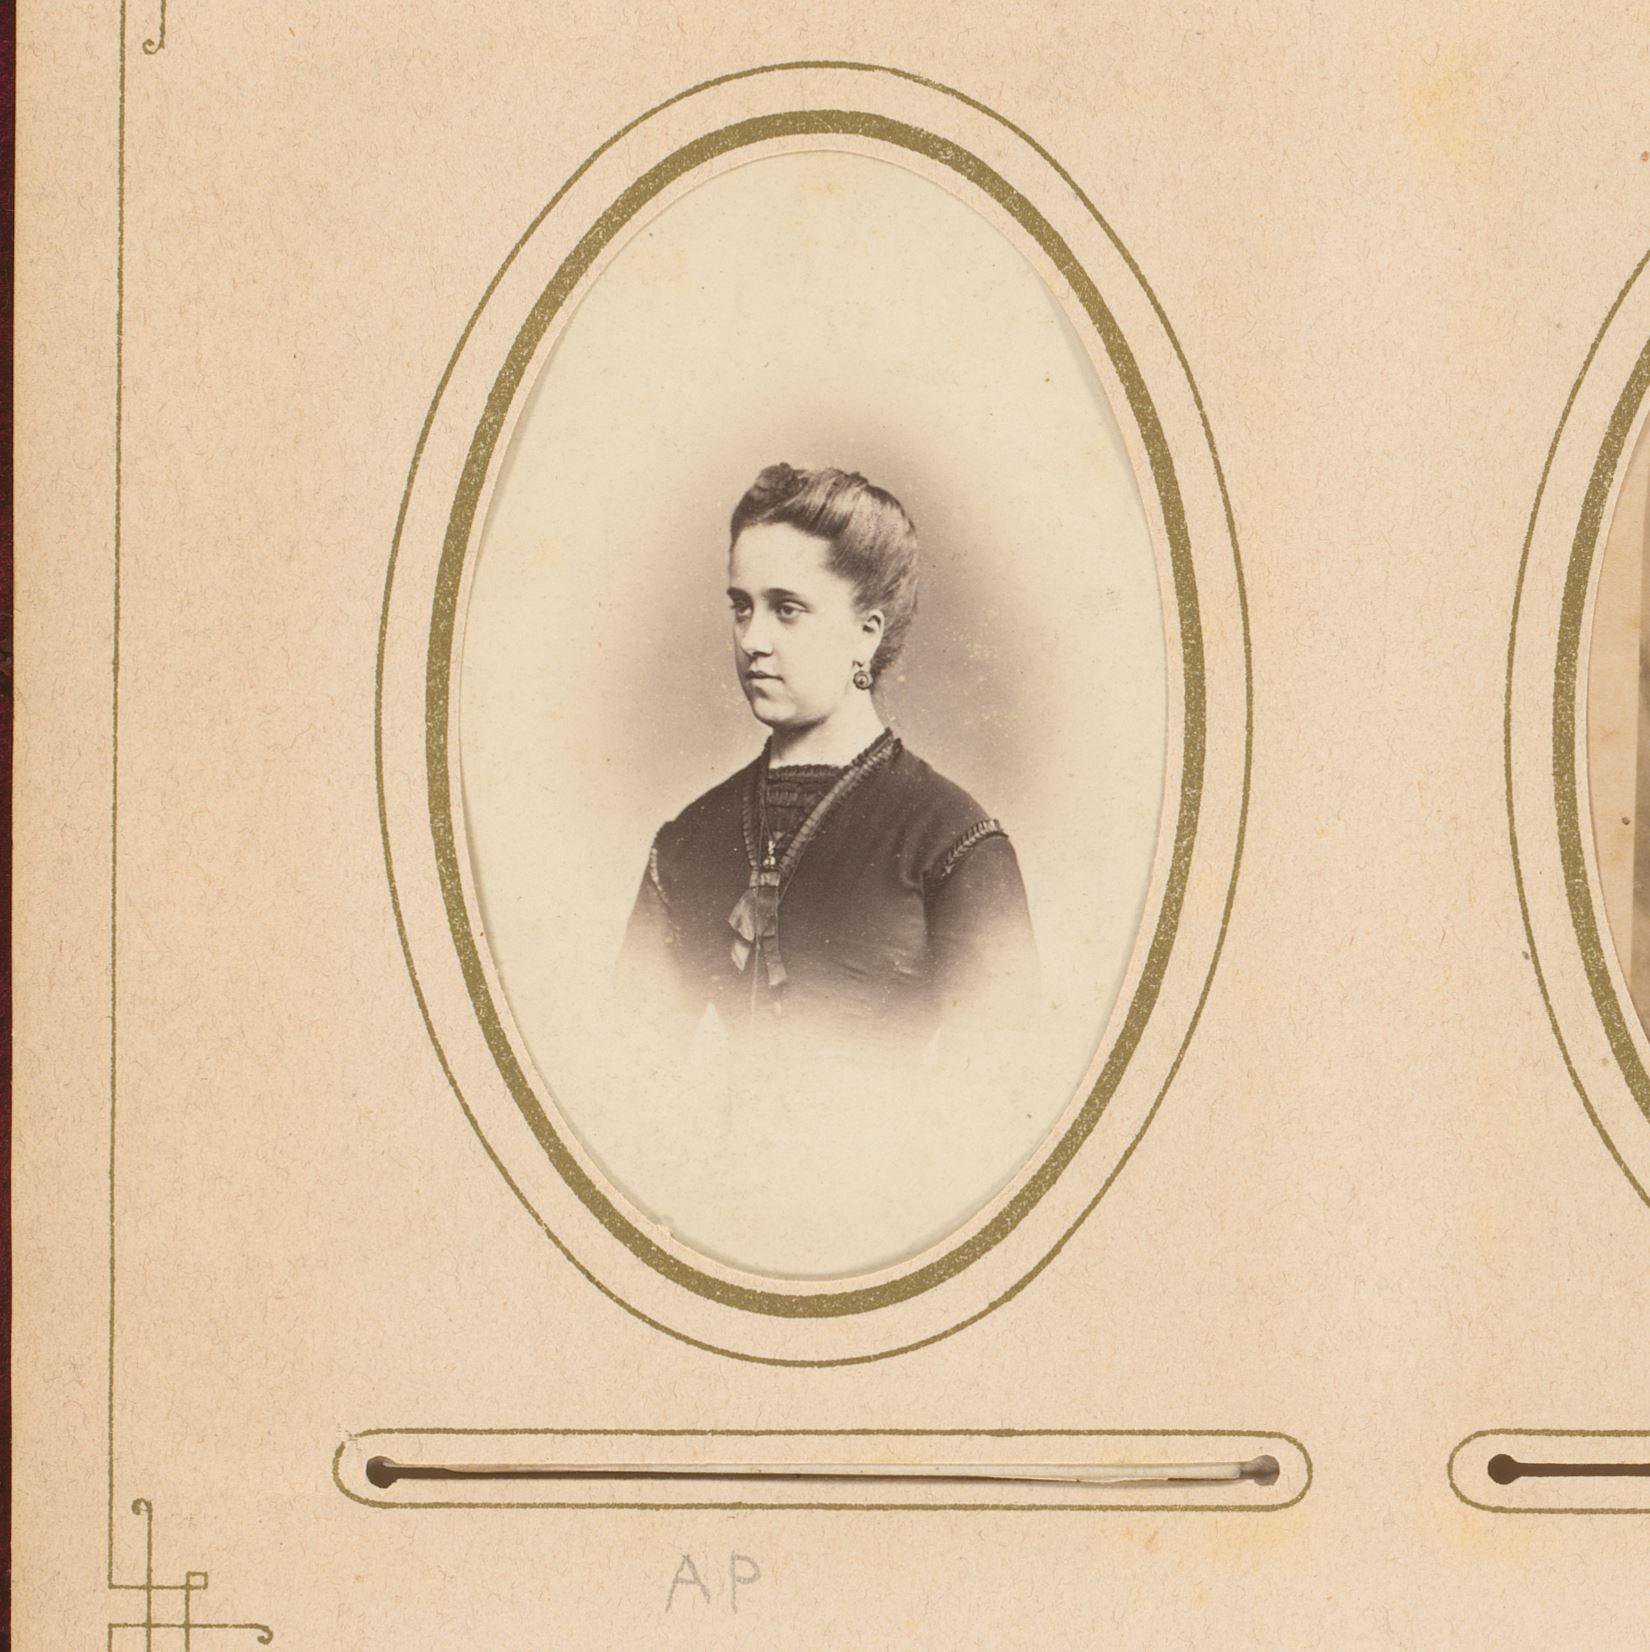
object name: photograph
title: Portret van een jonge vrouw met oorbellen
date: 1862-1882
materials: cardboard, photographic support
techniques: albumen print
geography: haarlem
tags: adolescent, young woman, maiden, historical persons - bb - woman, ear-rings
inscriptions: inscription: ‘CH. BINGER & Co./ PHOTOGRAPHISCHE INRIGTING/ ZIJLSTRAAT/ TE/ HAARLEM.’